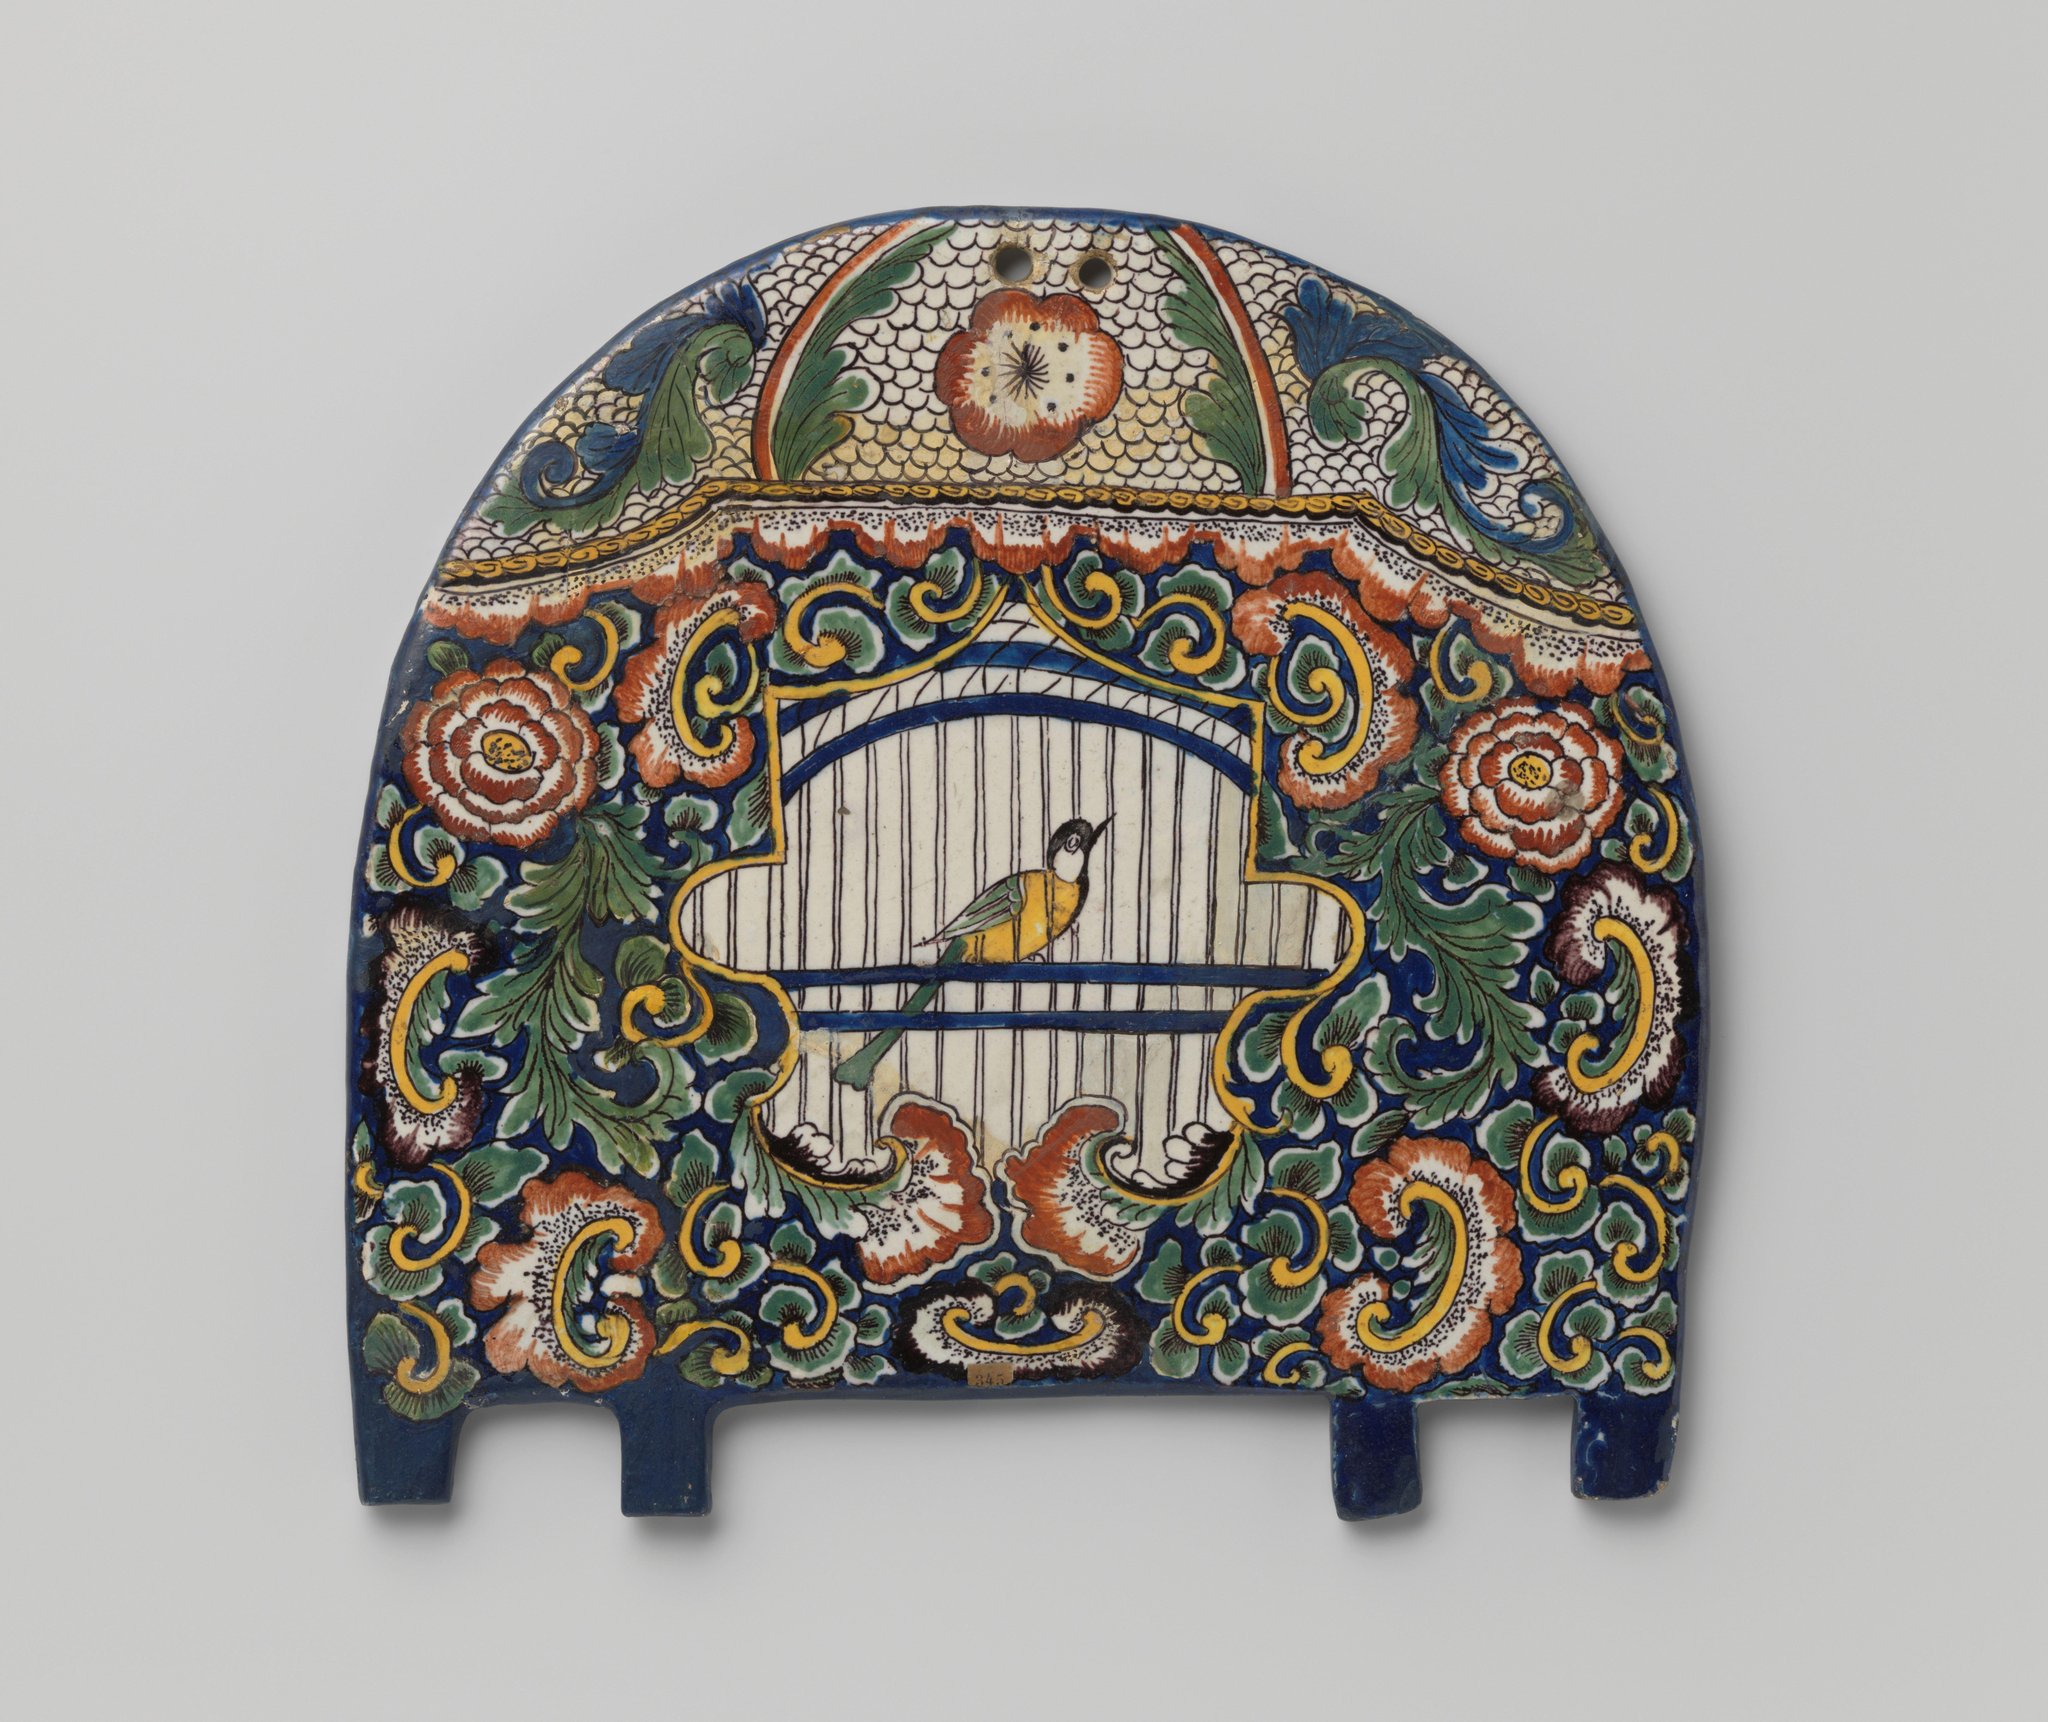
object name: sconce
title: Plaat, half elipsvormig, veelkleurig beschilderd met vogelkooi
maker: Anonymous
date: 1800-1920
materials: earthenware, glaze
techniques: painted, polychromy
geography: delft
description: Plaat, half elipsvormig, veelkleurig beschilderd onder het glazuur met vogelkooi en bloemenrand.